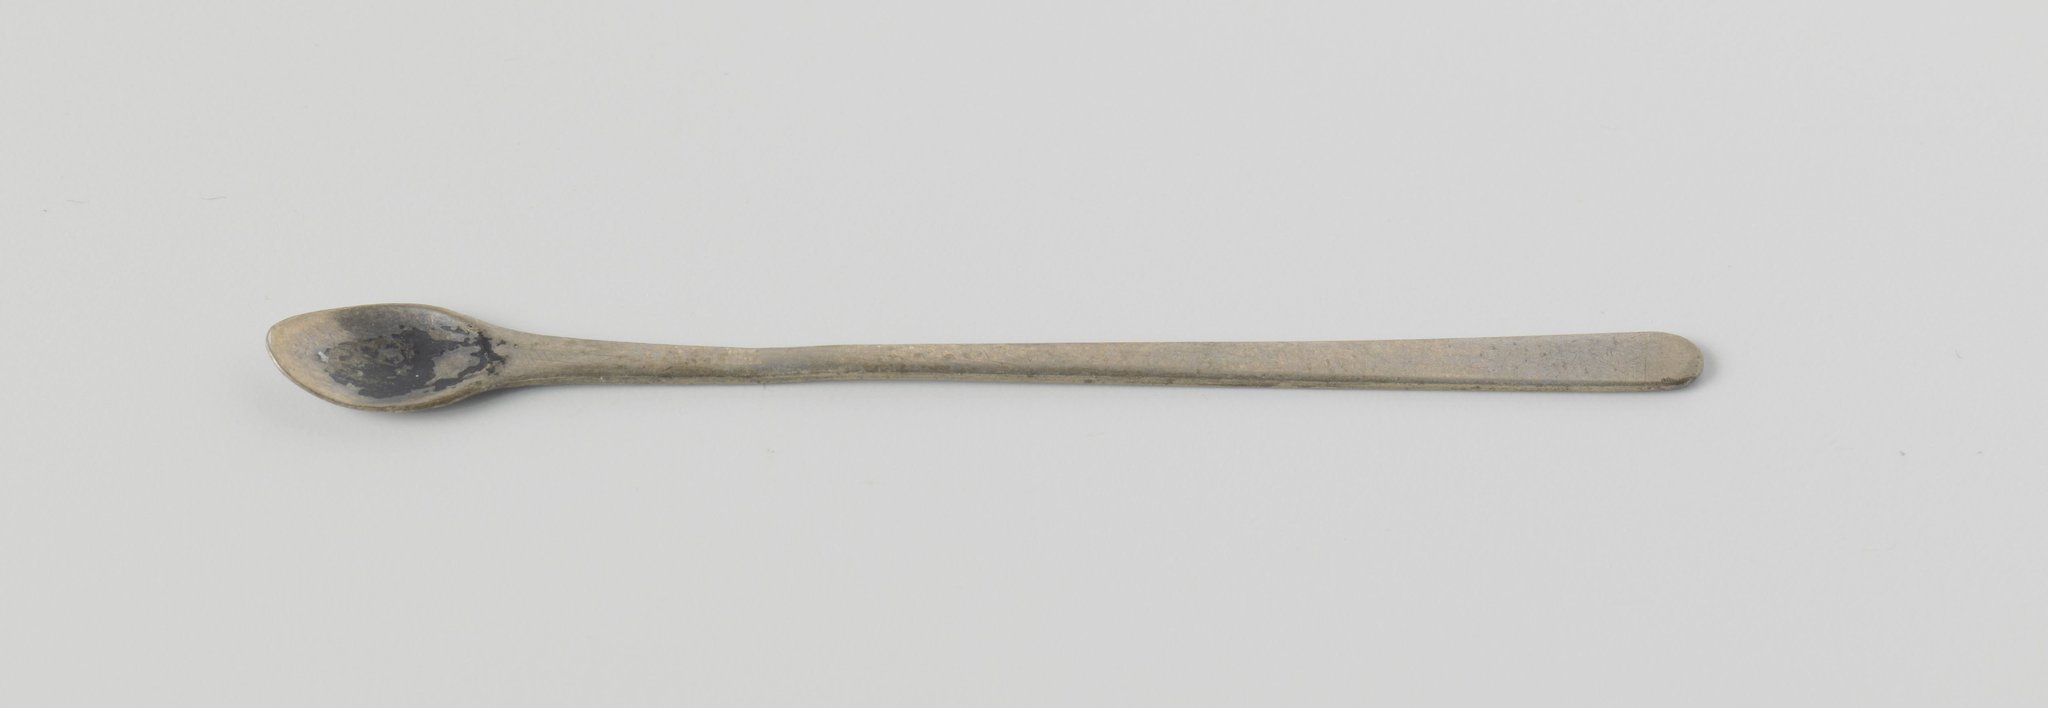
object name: miniature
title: Lepel met lange steel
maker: Anonymous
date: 1725-1775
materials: silver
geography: netherlands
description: Ovale lepel met lange, platte steel. De lepel is niet gemerkt.